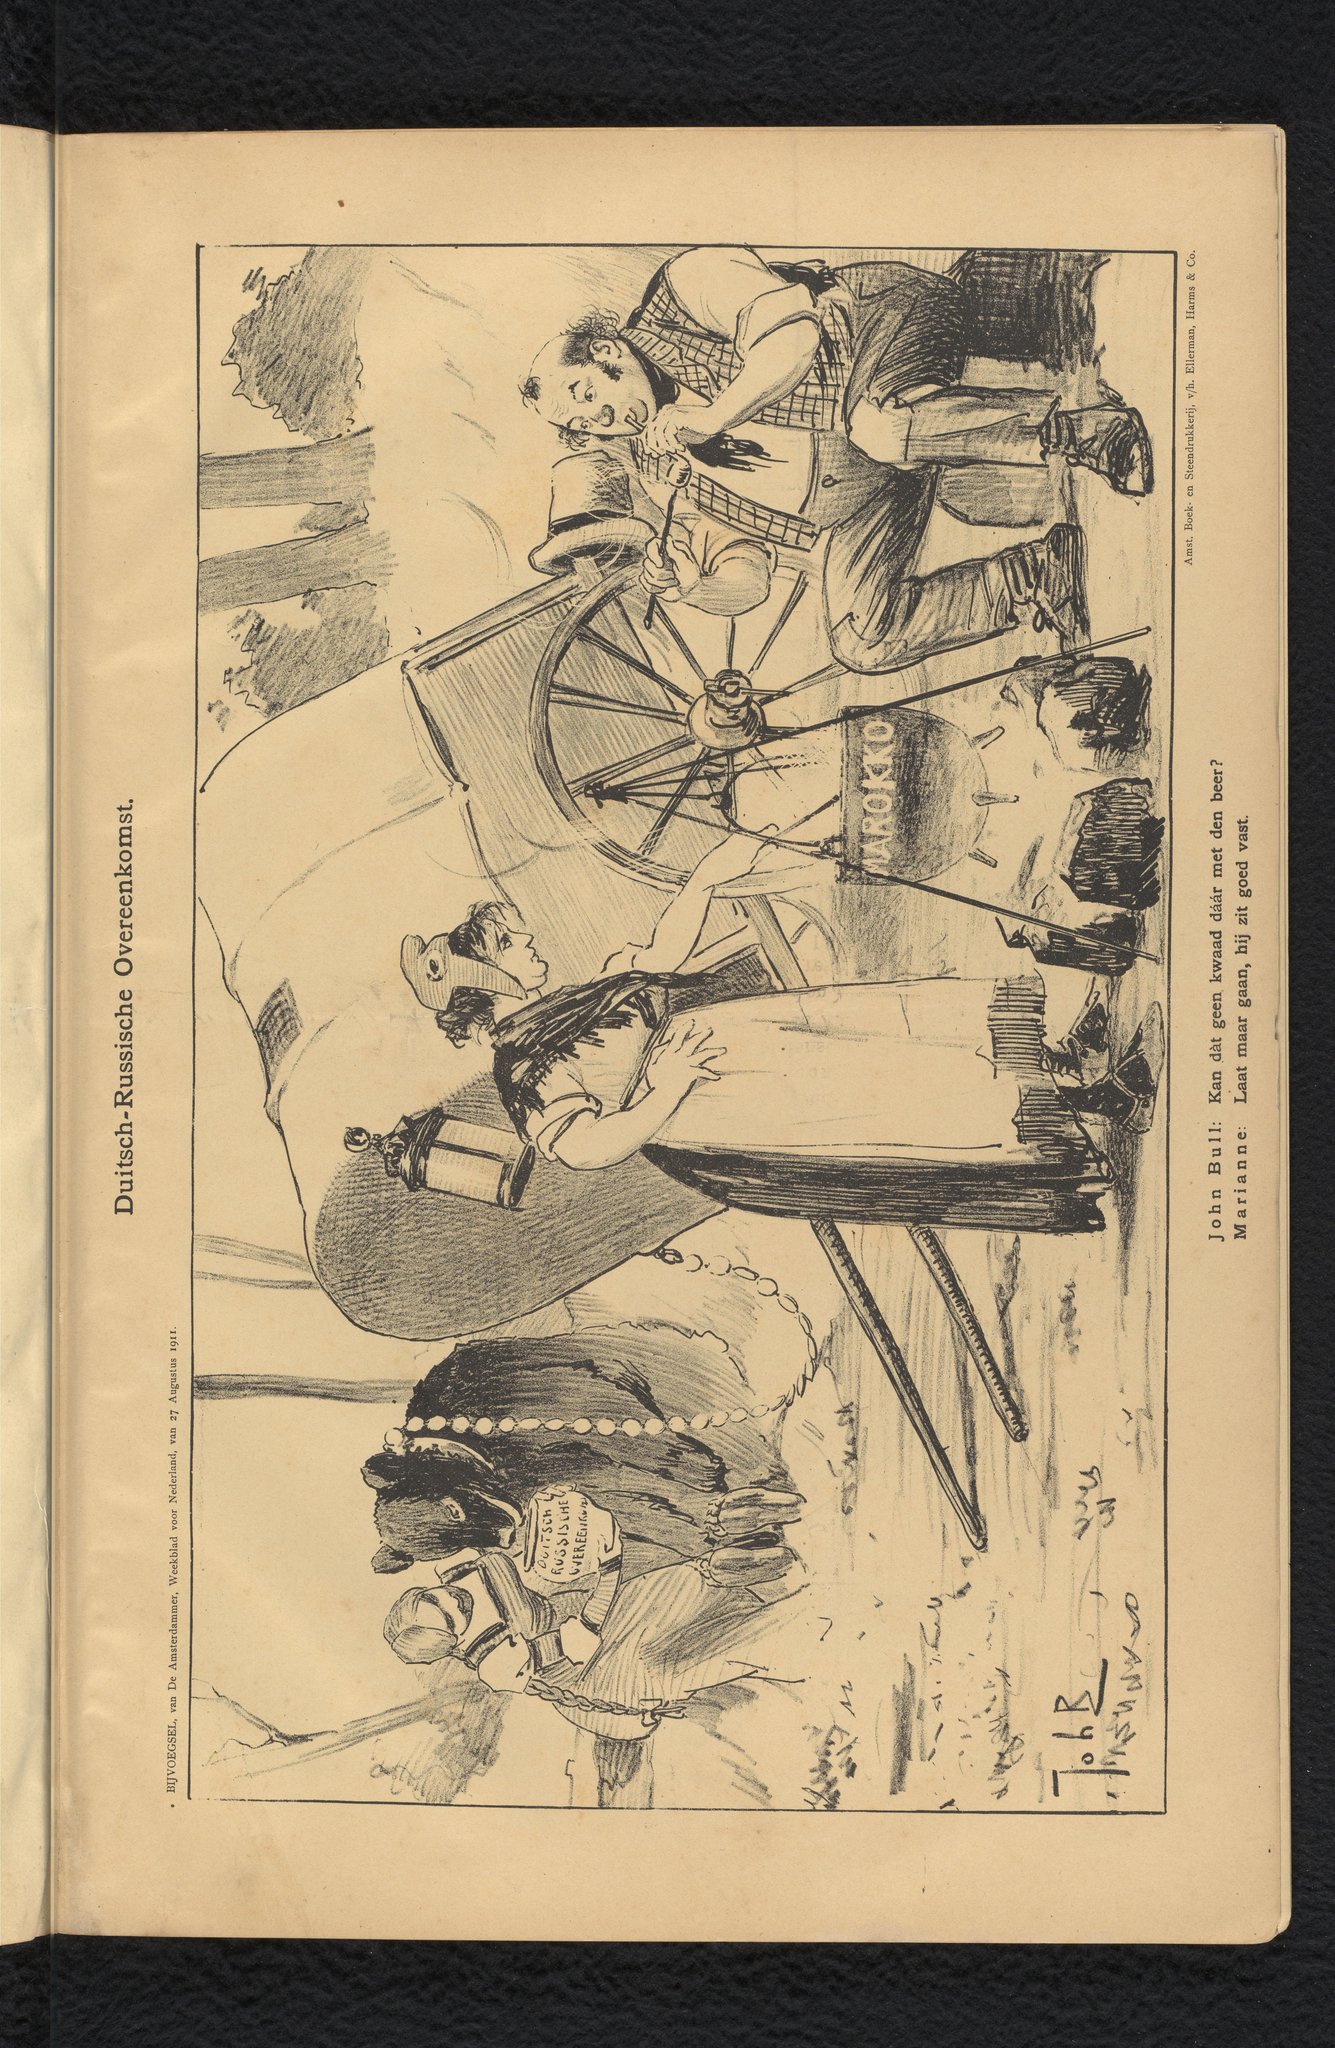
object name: cartoon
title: Duitsch-Russische Overeenkomst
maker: johan braakensiek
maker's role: draughtsman, print maker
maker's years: 1858-1940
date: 1911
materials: paper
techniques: lithograph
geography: amsterdam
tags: personifications of countries, nations, states, districts, etc., wandering communities: romani or roma, beasts of prey, predatory animals: bear, cooking food - cc - in the open air, political caricatures and satires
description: John Bull (Engeland) en Marianne (Franrijk) als een Roma-familie met een beer en met de kookpot 'Marokko' op het kampvuur. Op de achtergrond voert Duitsland de geketende Russische beer.